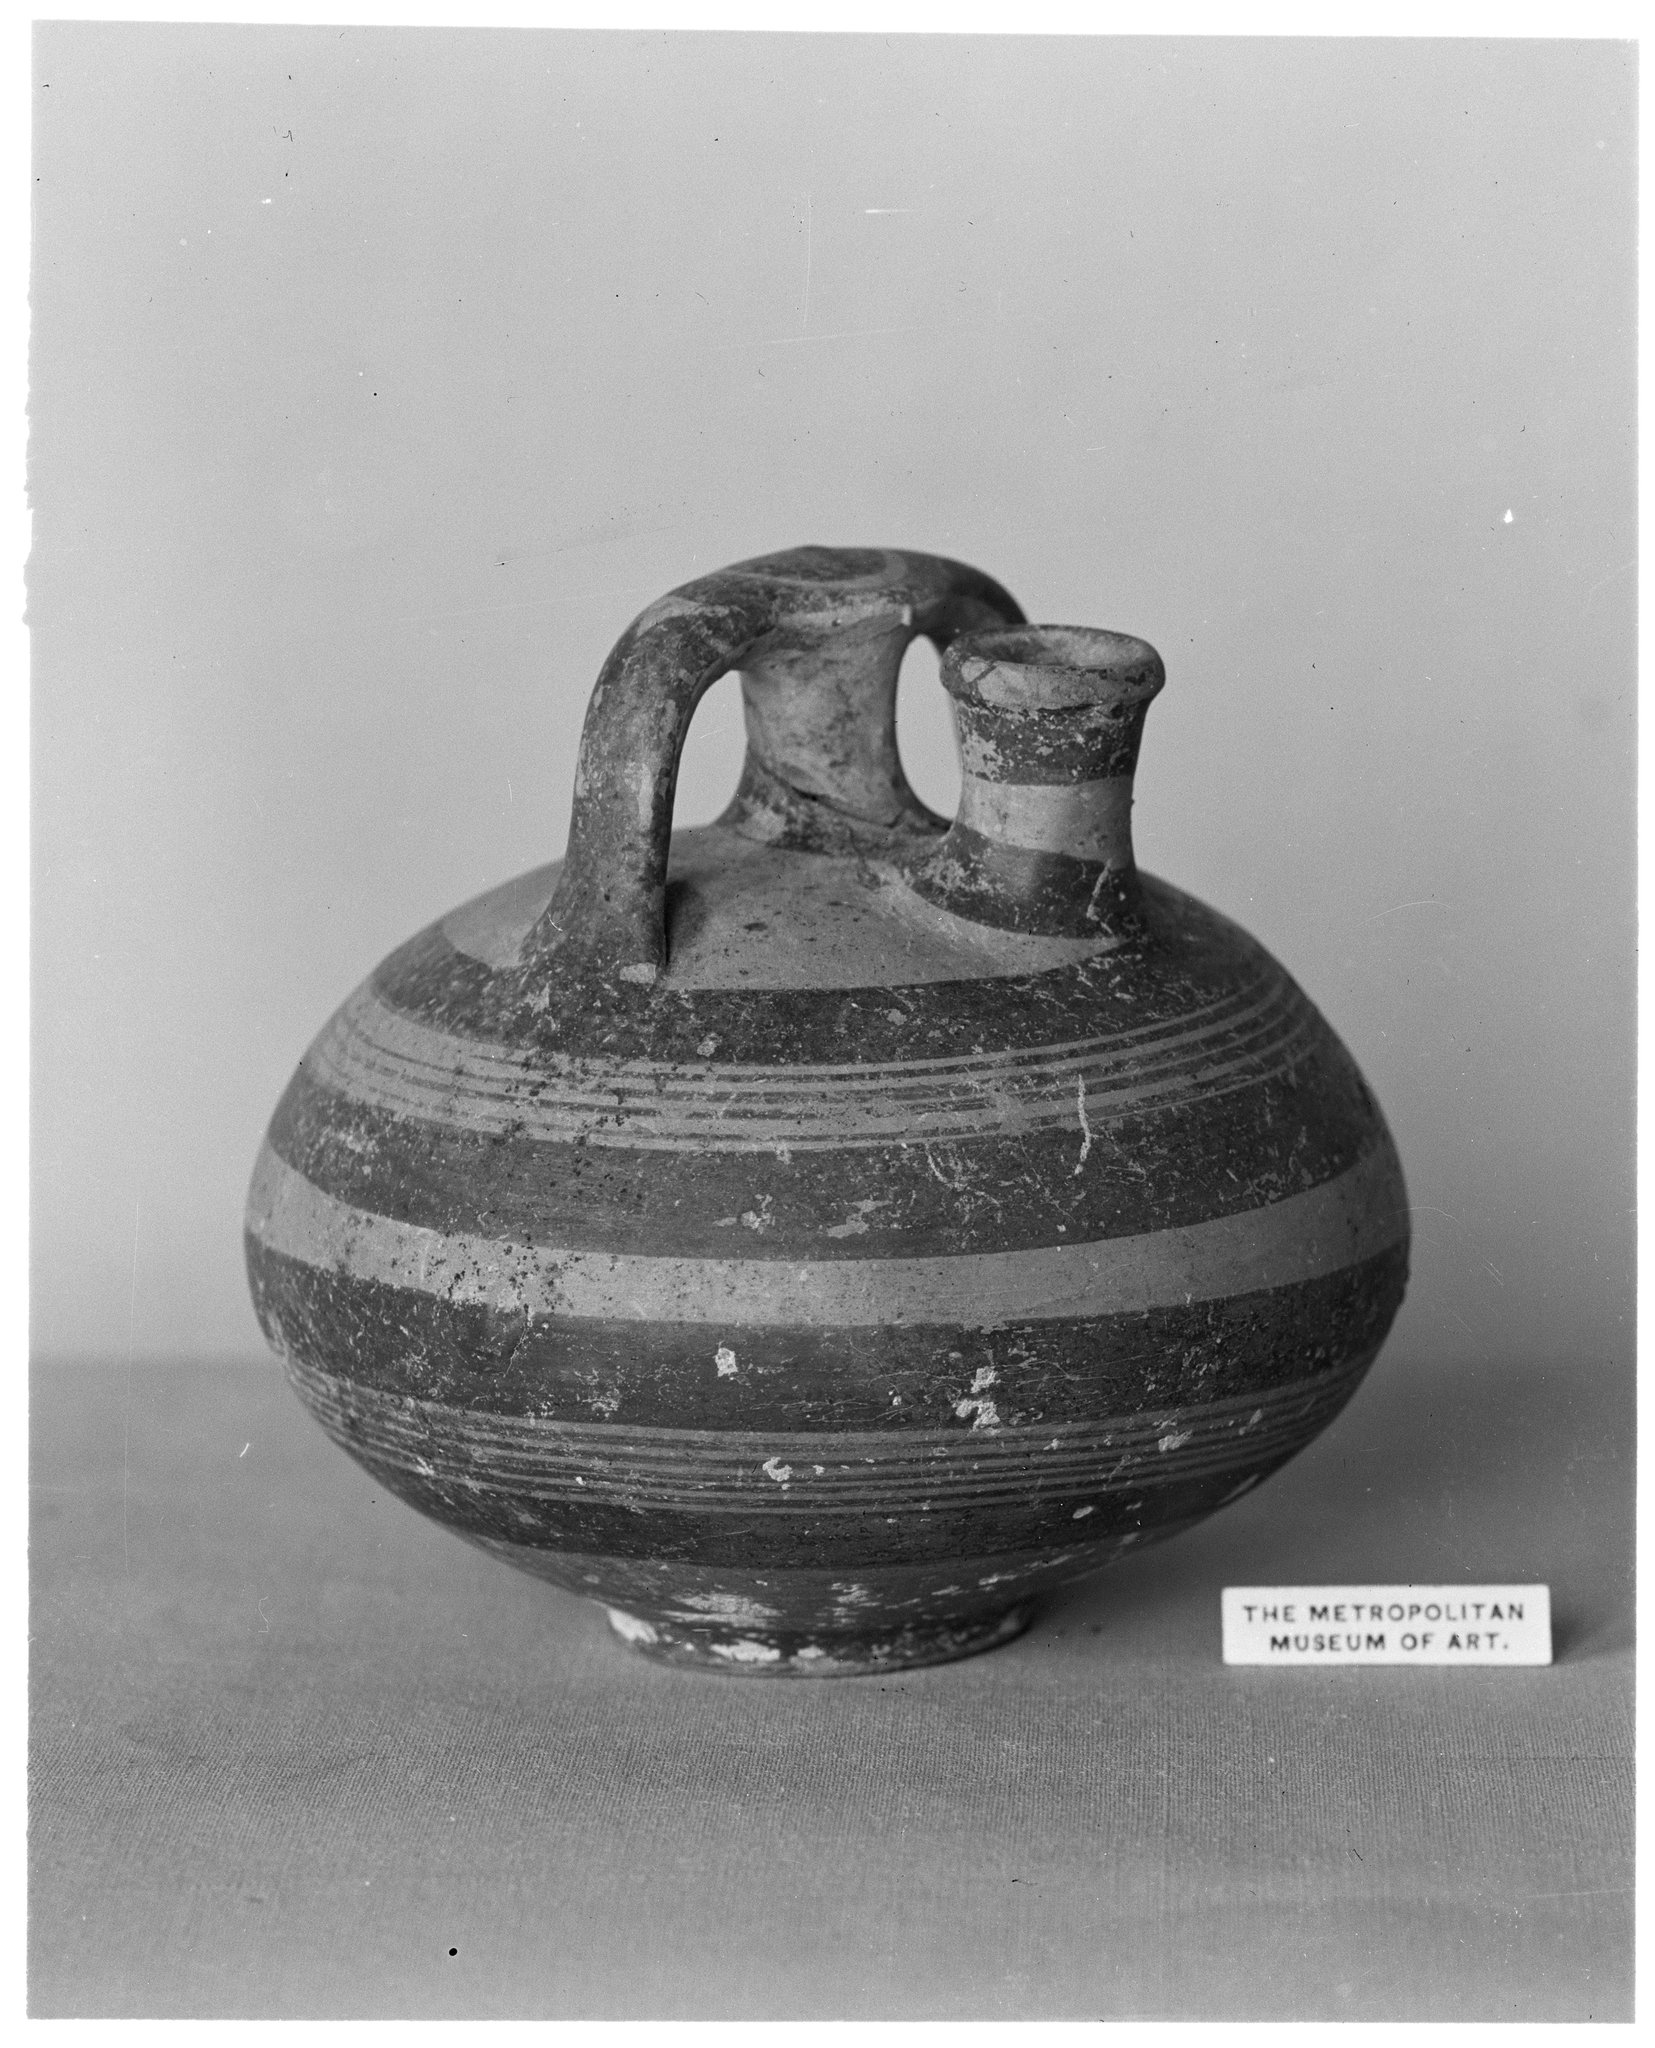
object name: false necked jar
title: Terracotta stirrup jar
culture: aegean, helladic or mycenaean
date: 1400-1300 BCE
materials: terracotta